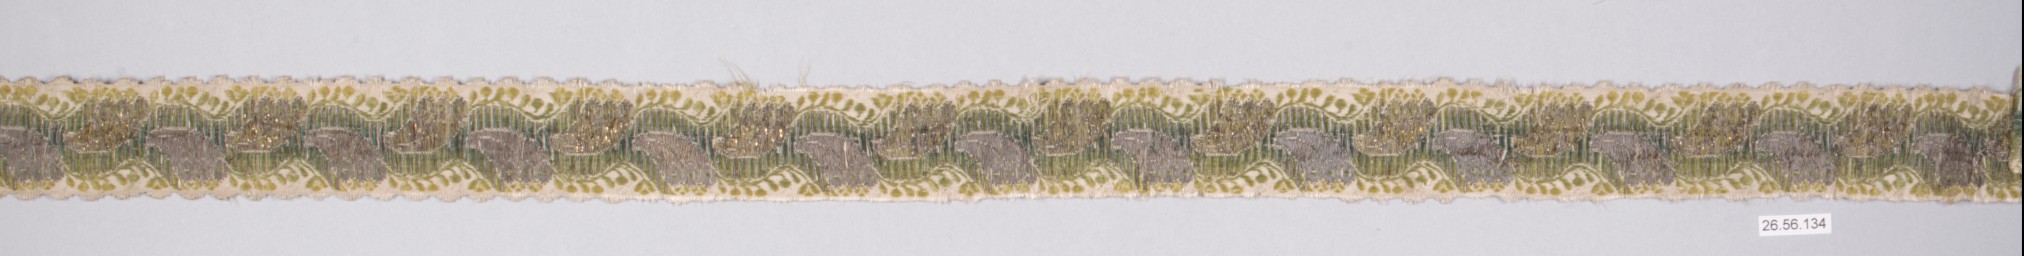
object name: ribbon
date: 1801-1900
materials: metal thread, silk